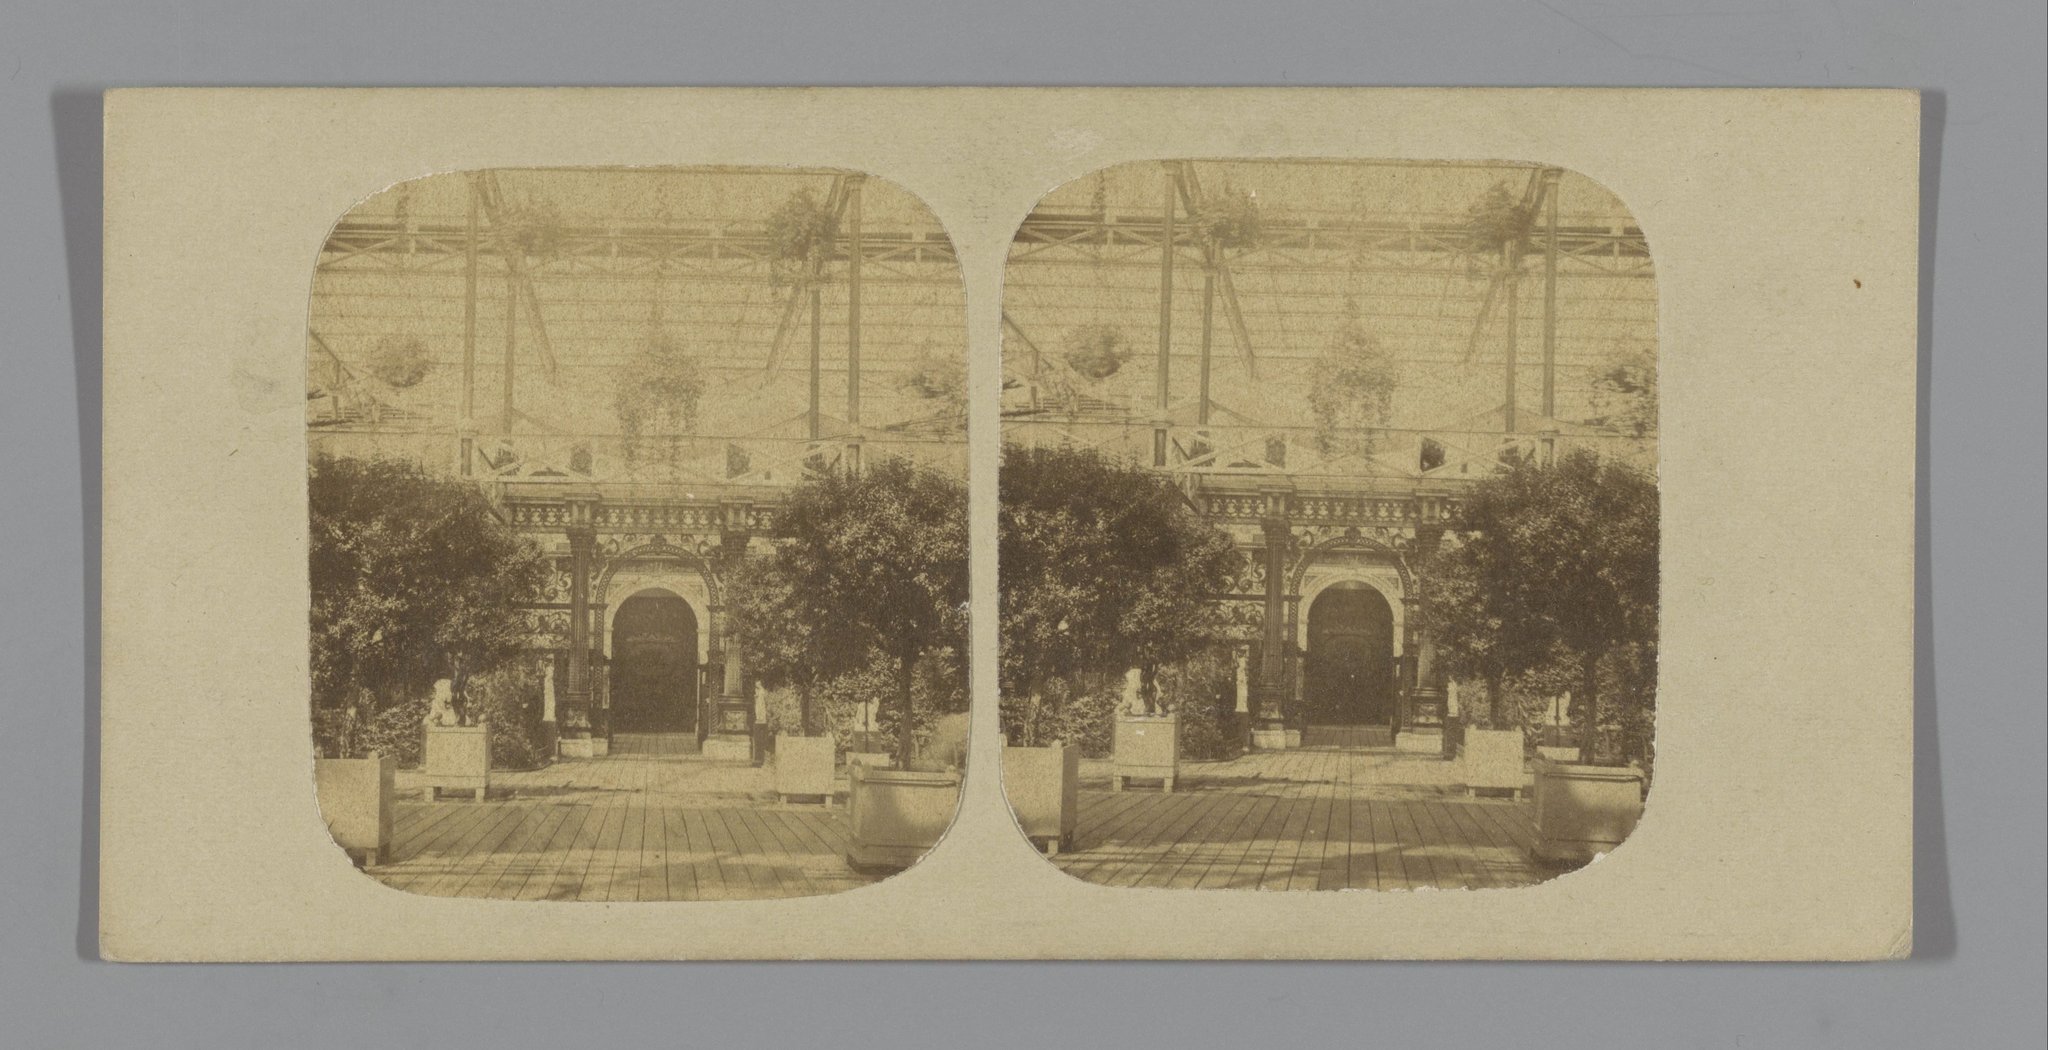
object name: stereograph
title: Stereoscopic illustrations of the Crystal Palace, at Sydenham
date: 1854-1859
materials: cardboard, photographic support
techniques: albumen print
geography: crystal palace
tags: crystal palace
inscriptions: number: ‘4x’